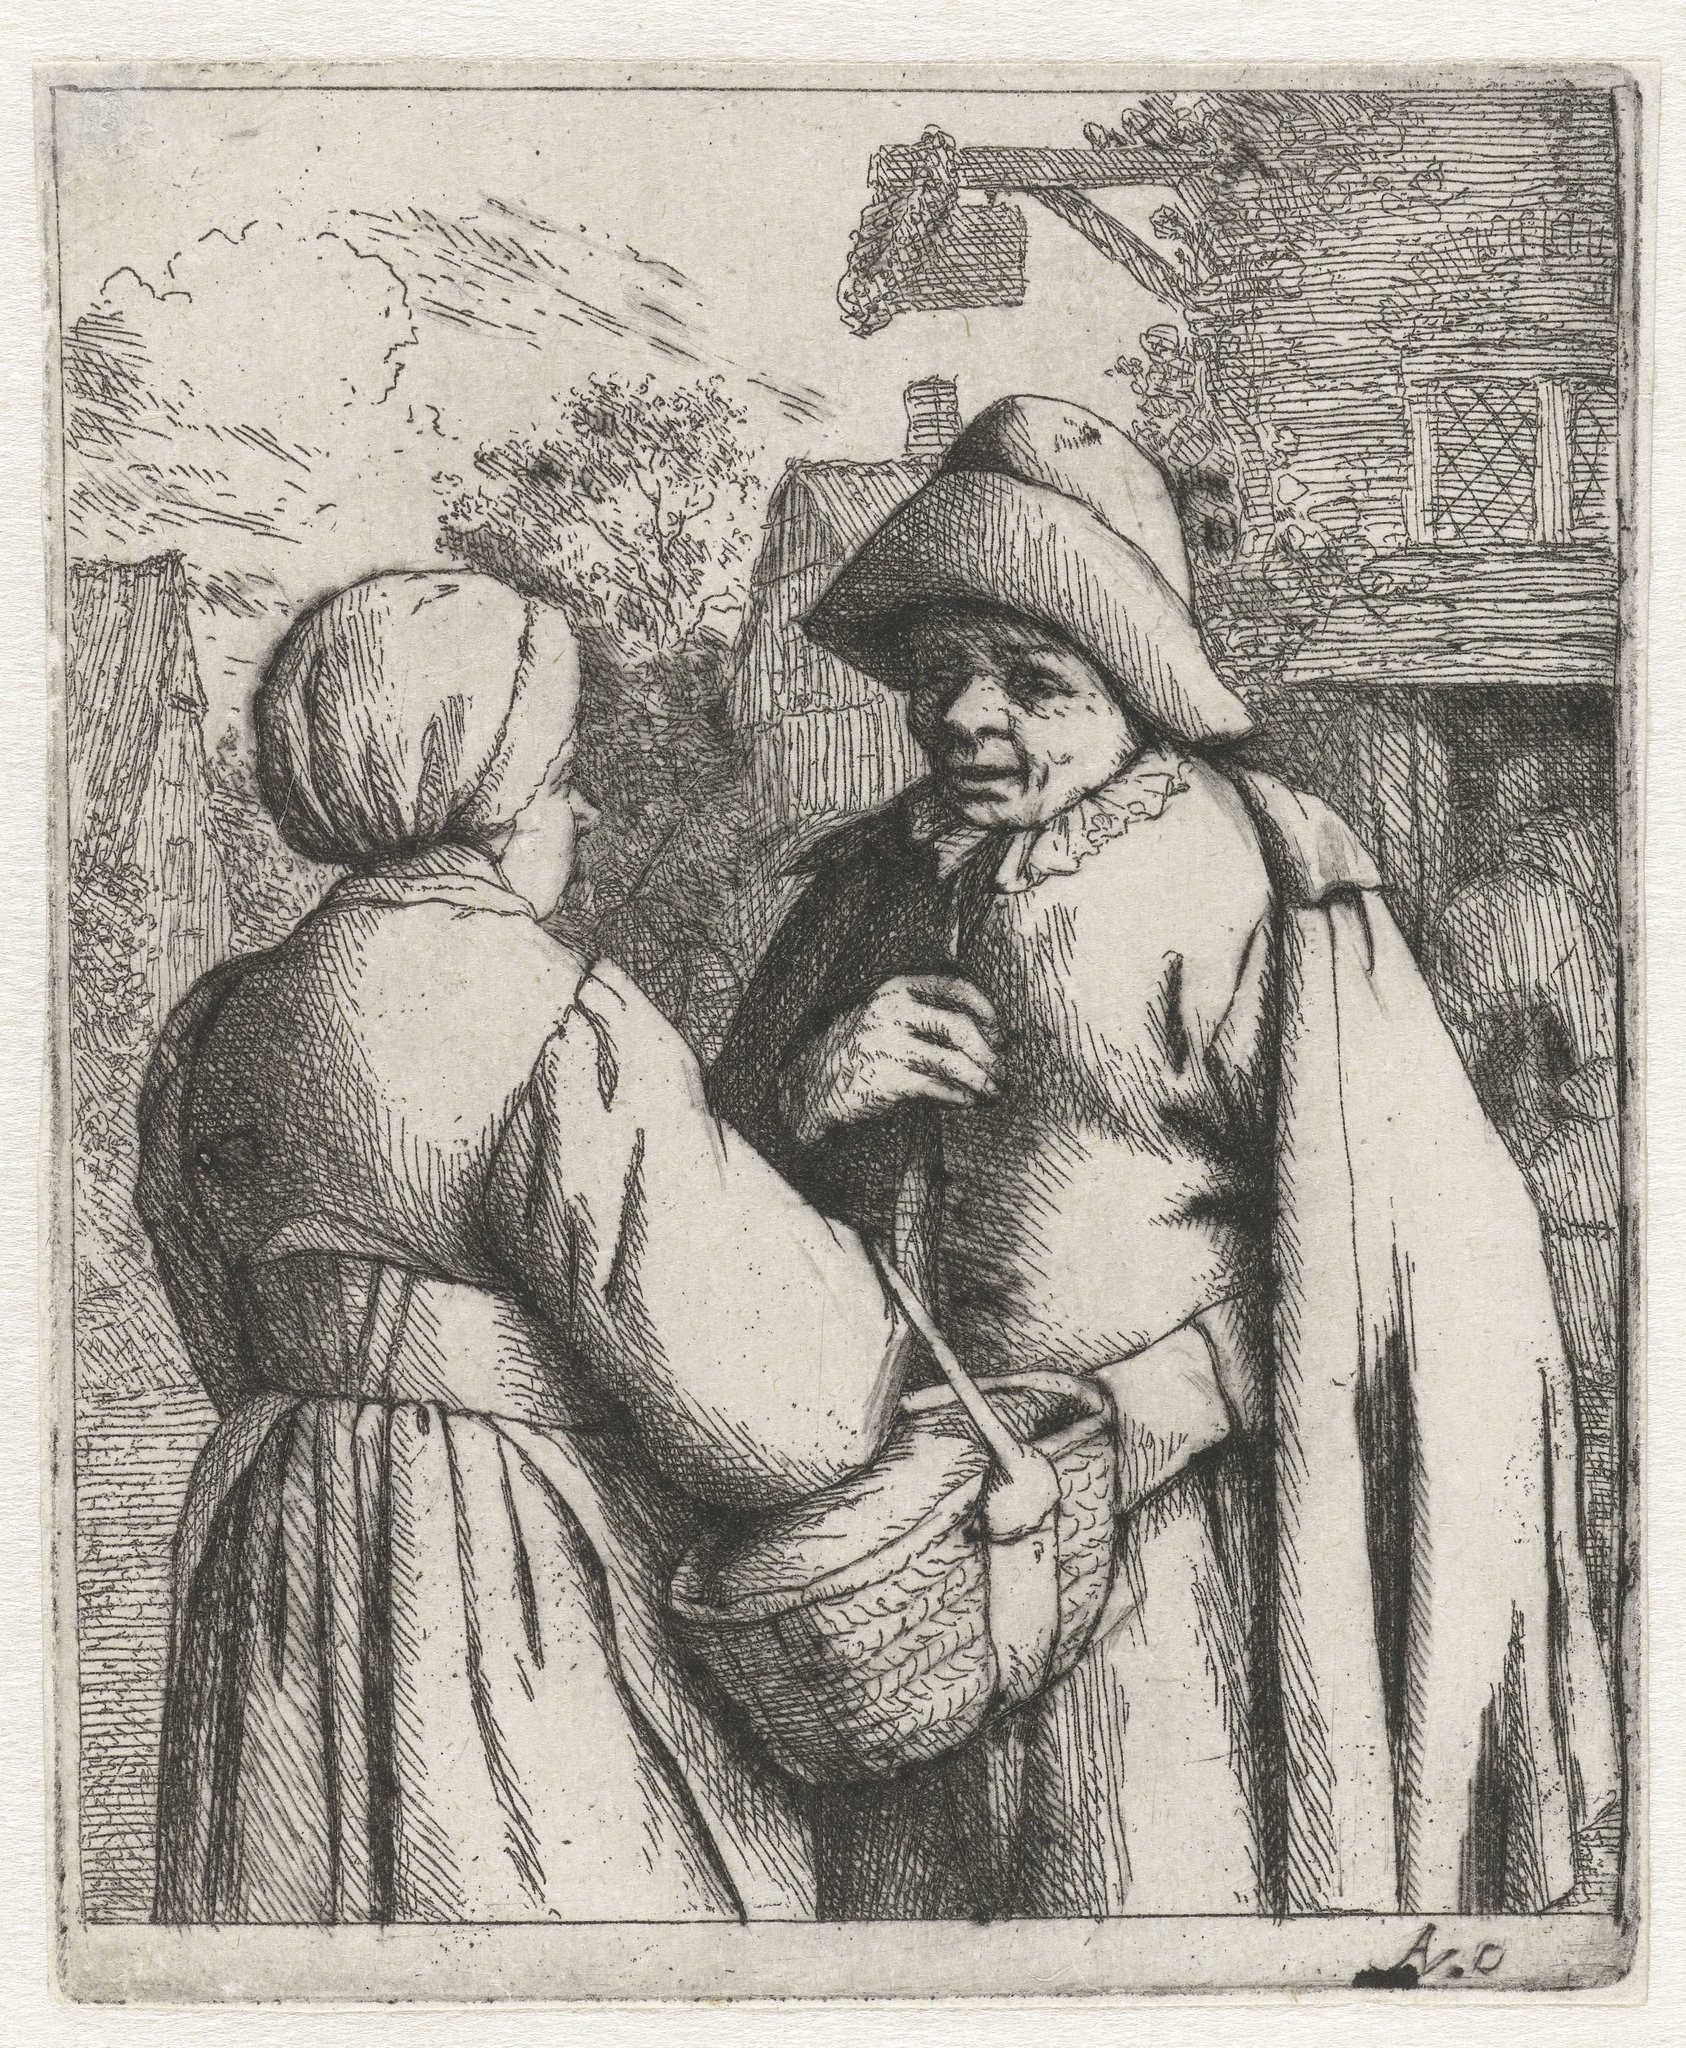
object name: print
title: Vrouw en man met elkaar in gesprek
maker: adriaen van ostade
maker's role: draughtsman, painter, print maker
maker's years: 1610-1685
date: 1668-1678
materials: paper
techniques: etching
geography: haarlem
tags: speaking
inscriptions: collector's mark: Lugt 240